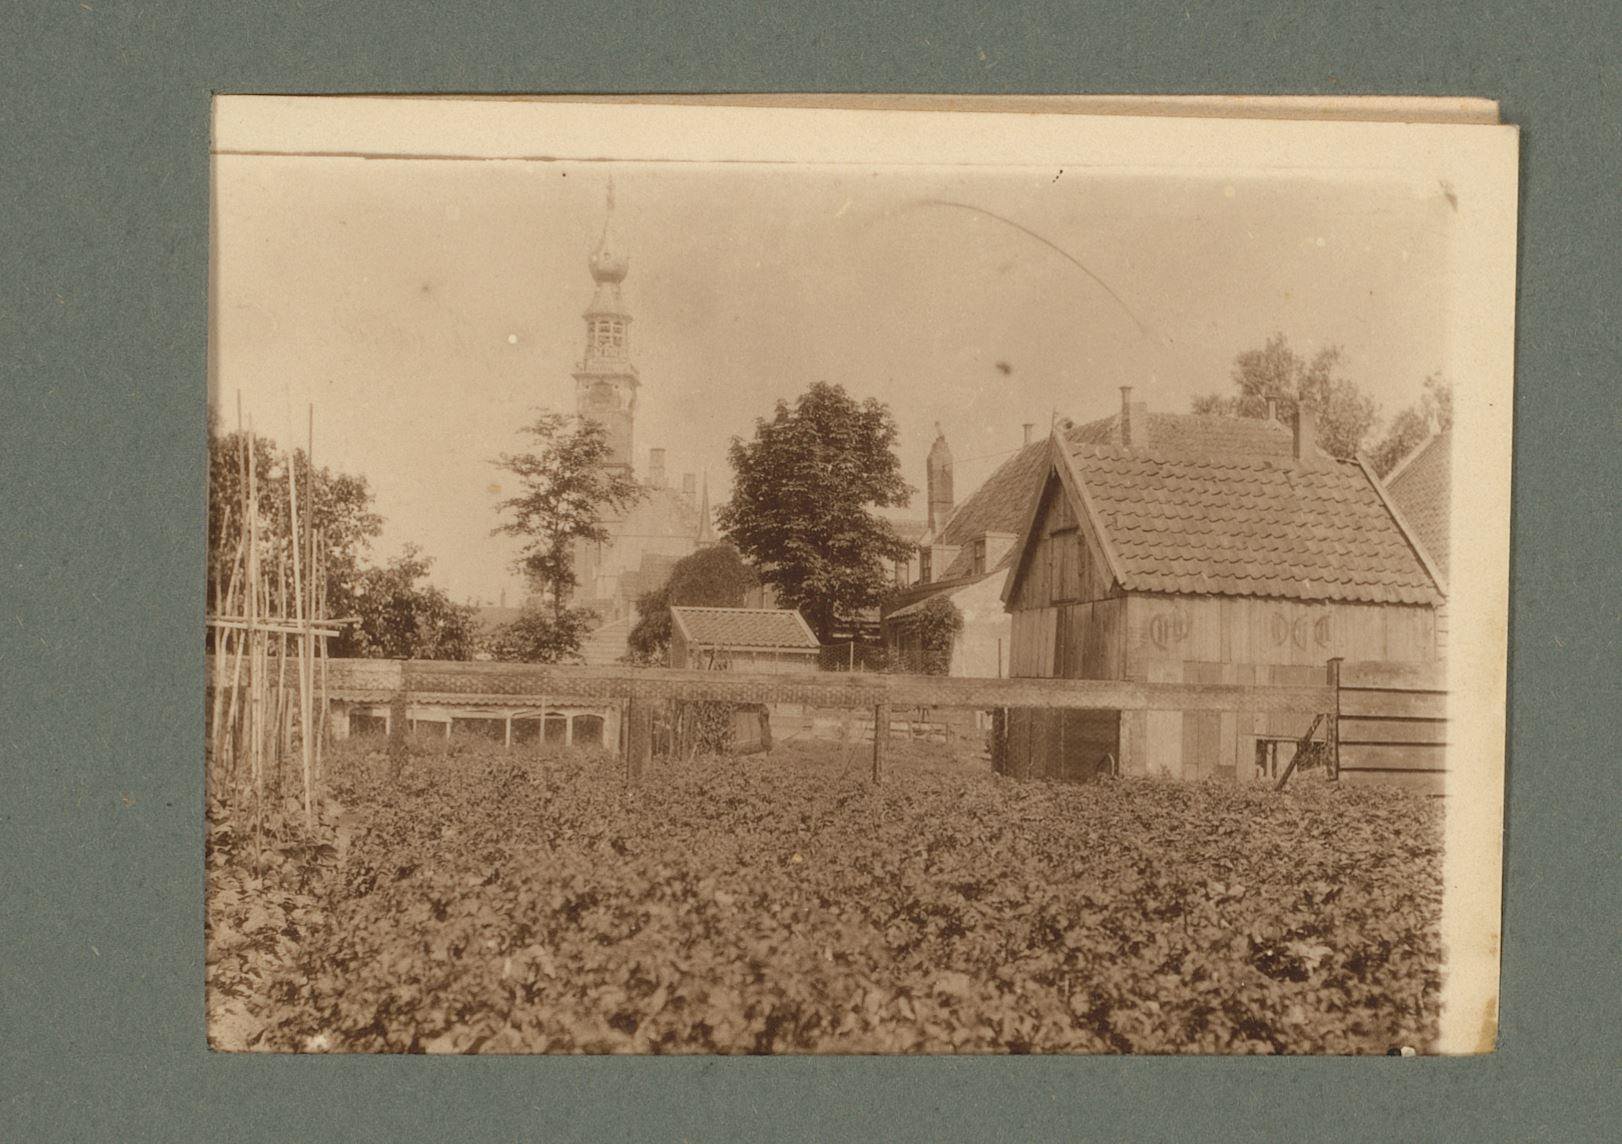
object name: album leaf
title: Gezicht op een moestuin met een kerktoren op de achtergrond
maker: george hidderley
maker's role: fotograaf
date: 1920-1940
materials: photographic support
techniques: daylight paper print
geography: netherlands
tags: garden, parts of church exterior and annexes: tower